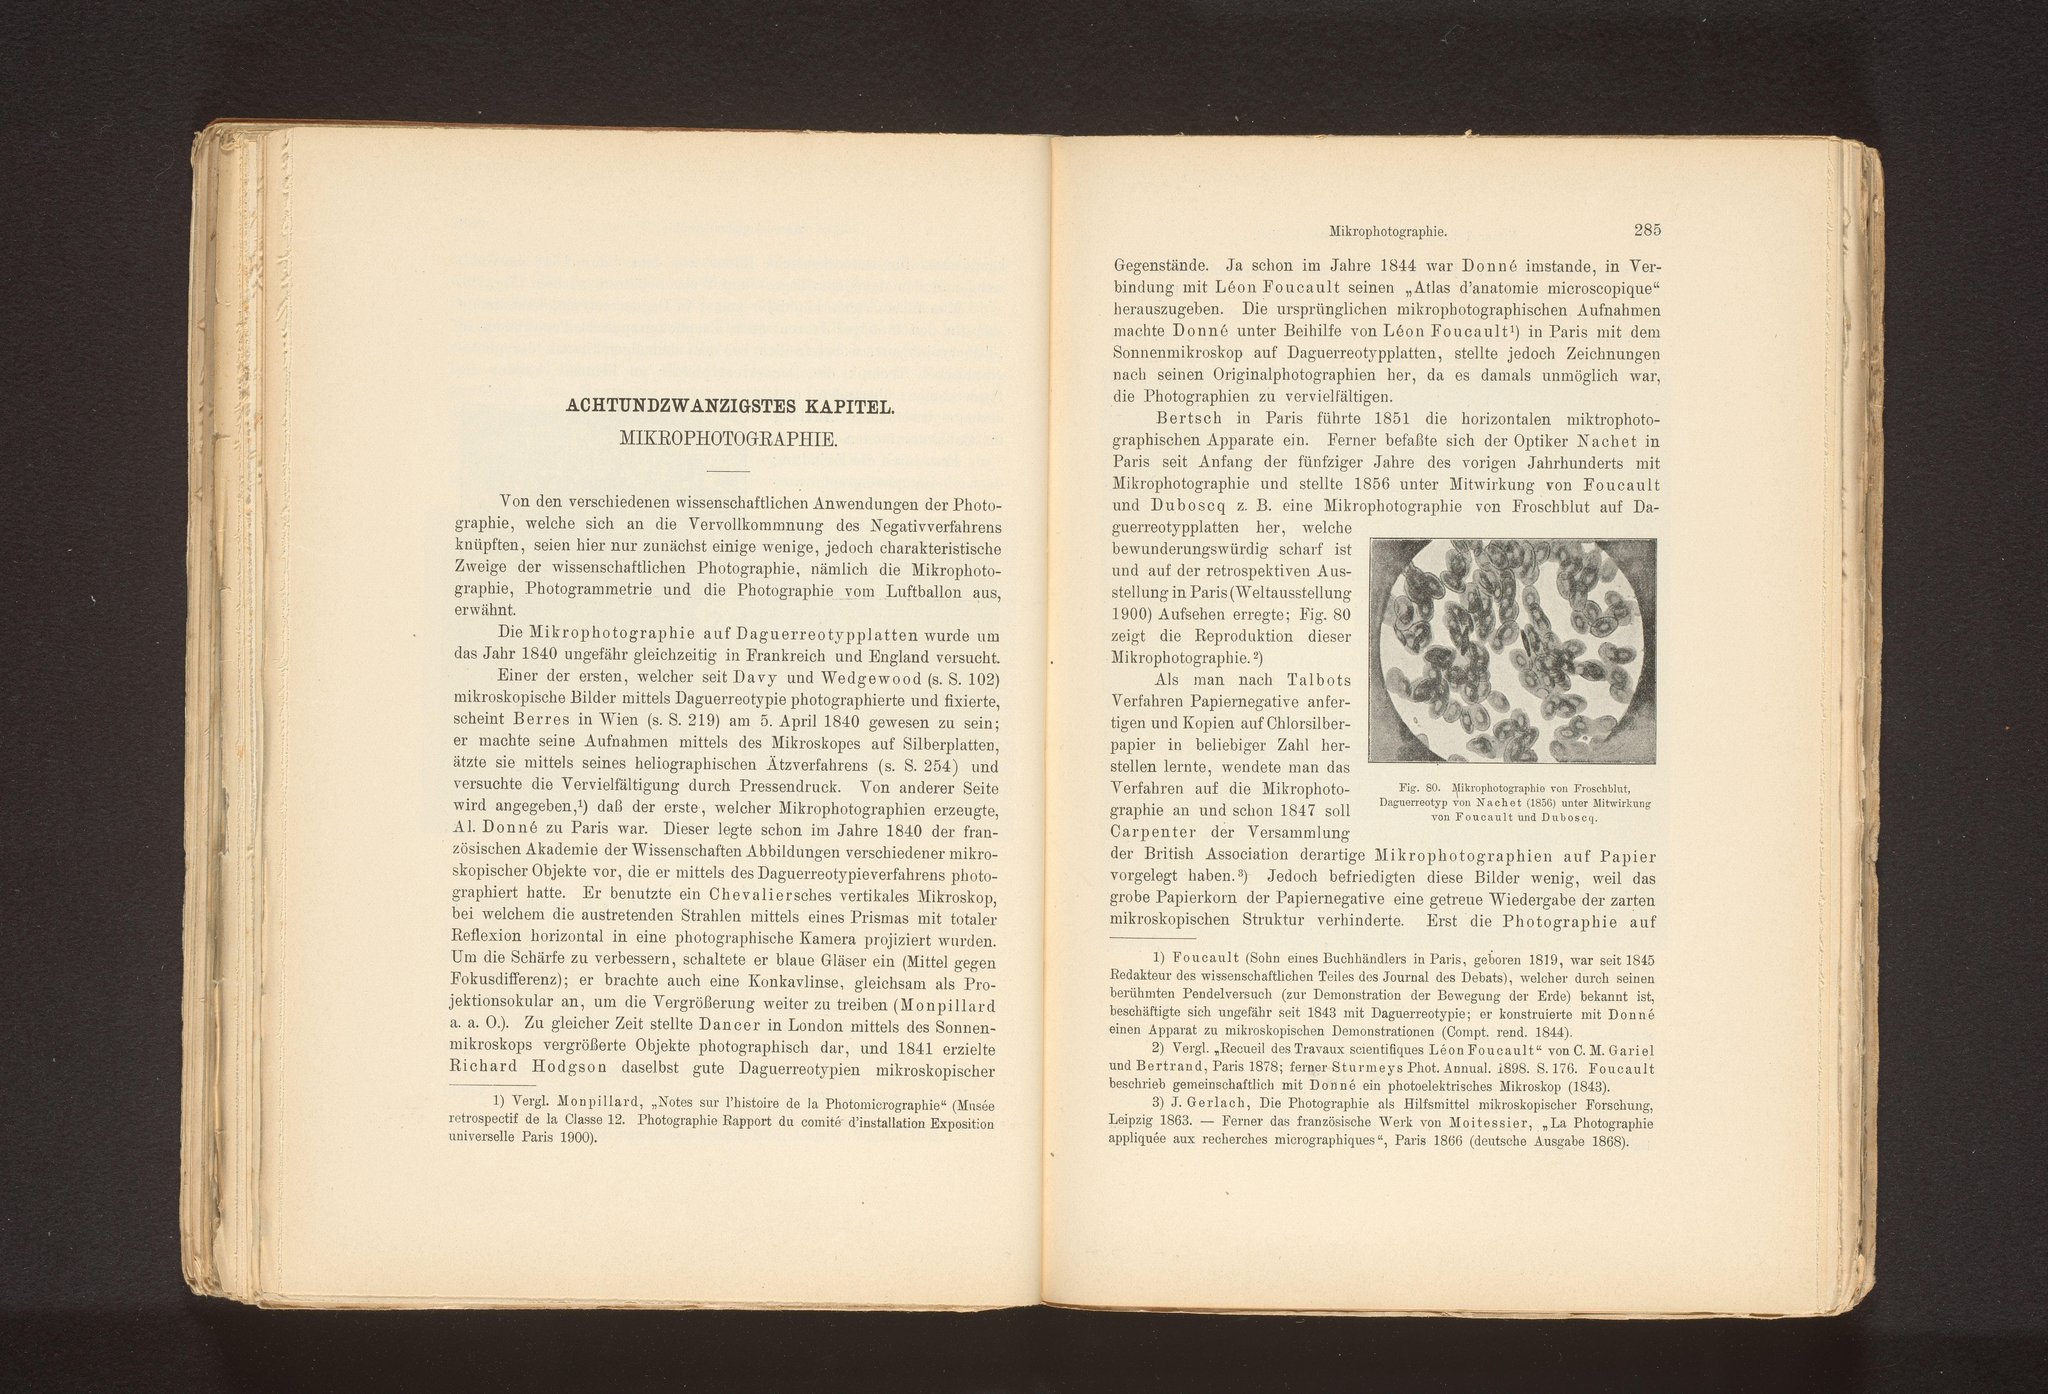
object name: page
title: Microscopische vergroting van kikkerbloed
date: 1900-1905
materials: paper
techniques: autotype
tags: tailless amphibians: frog, blood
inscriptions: inscription: ‘Daguerreotyp (...) und Duboscq’, number: ‘Fig. 80.’